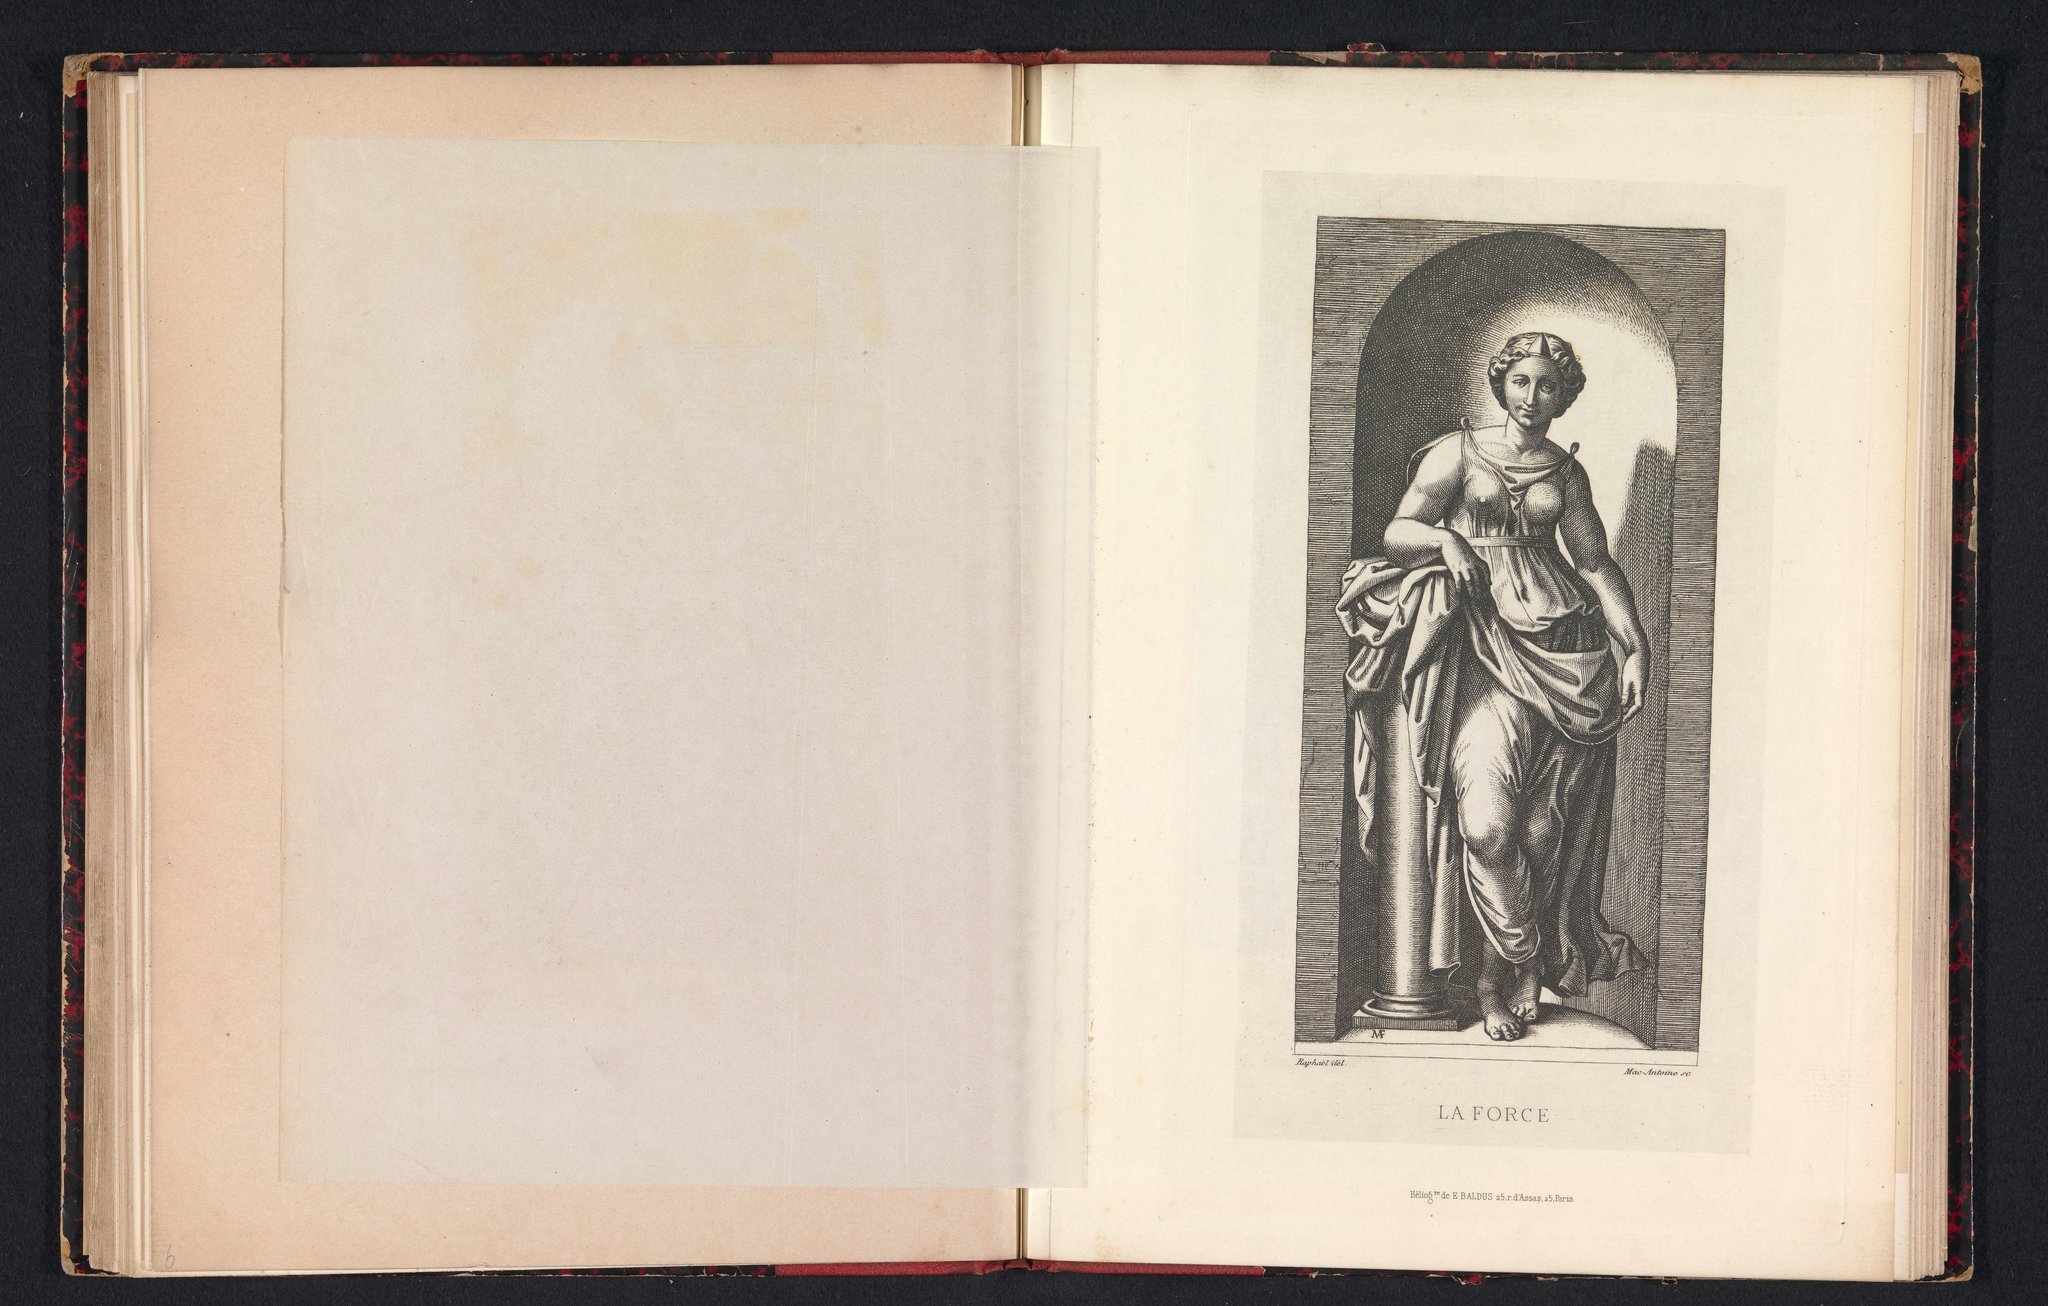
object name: page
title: La force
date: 1859-1869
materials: paper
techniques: photoaquatint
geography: italy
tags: strength, power; 'fortezza', 'fortezza d'animo e di corpo', 'fortezza del corpo congiunta con la generosità dell'animo', 'fortezza & valore del corpo congiunto con la prudenza & virtù del animo', 'forza' (ripa)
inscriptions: name: ‘E BALDUS 25 r.d'Assas, 25, Paris’